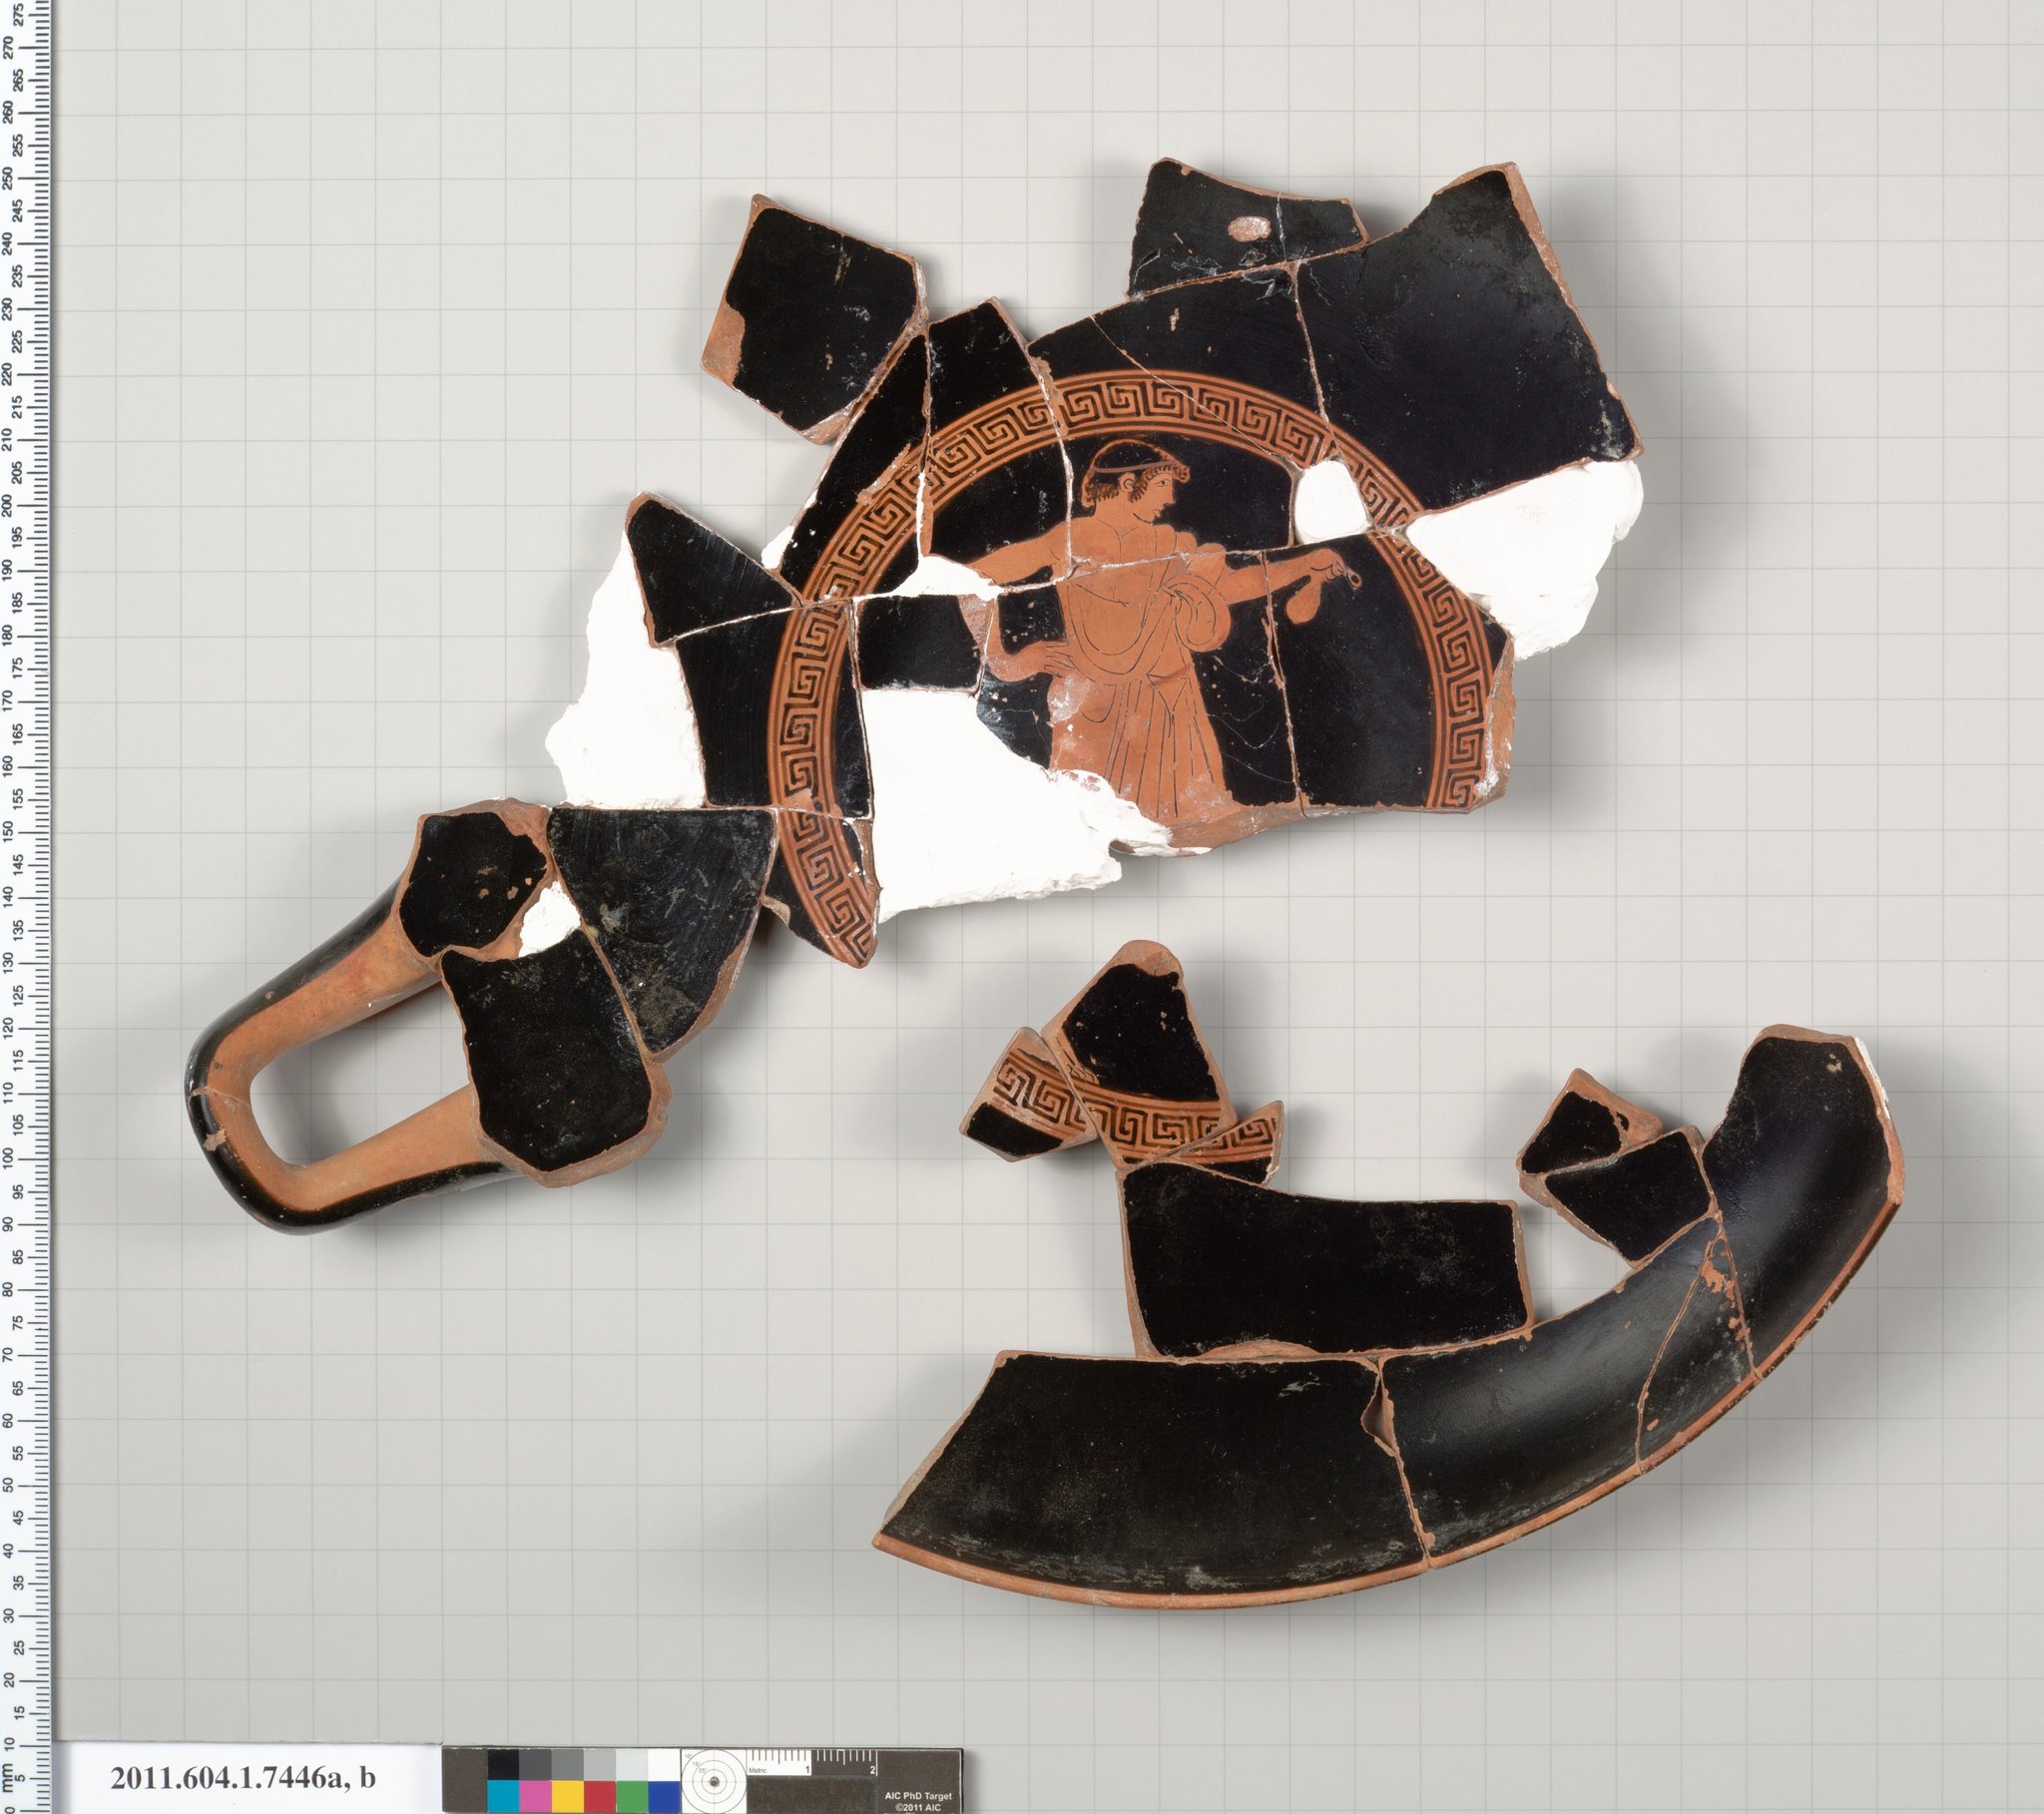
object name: kylix fragment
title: Terracotta fragments of a kylix (drinking cup)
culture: greek, attic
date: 490-470 BCE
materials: terracotta